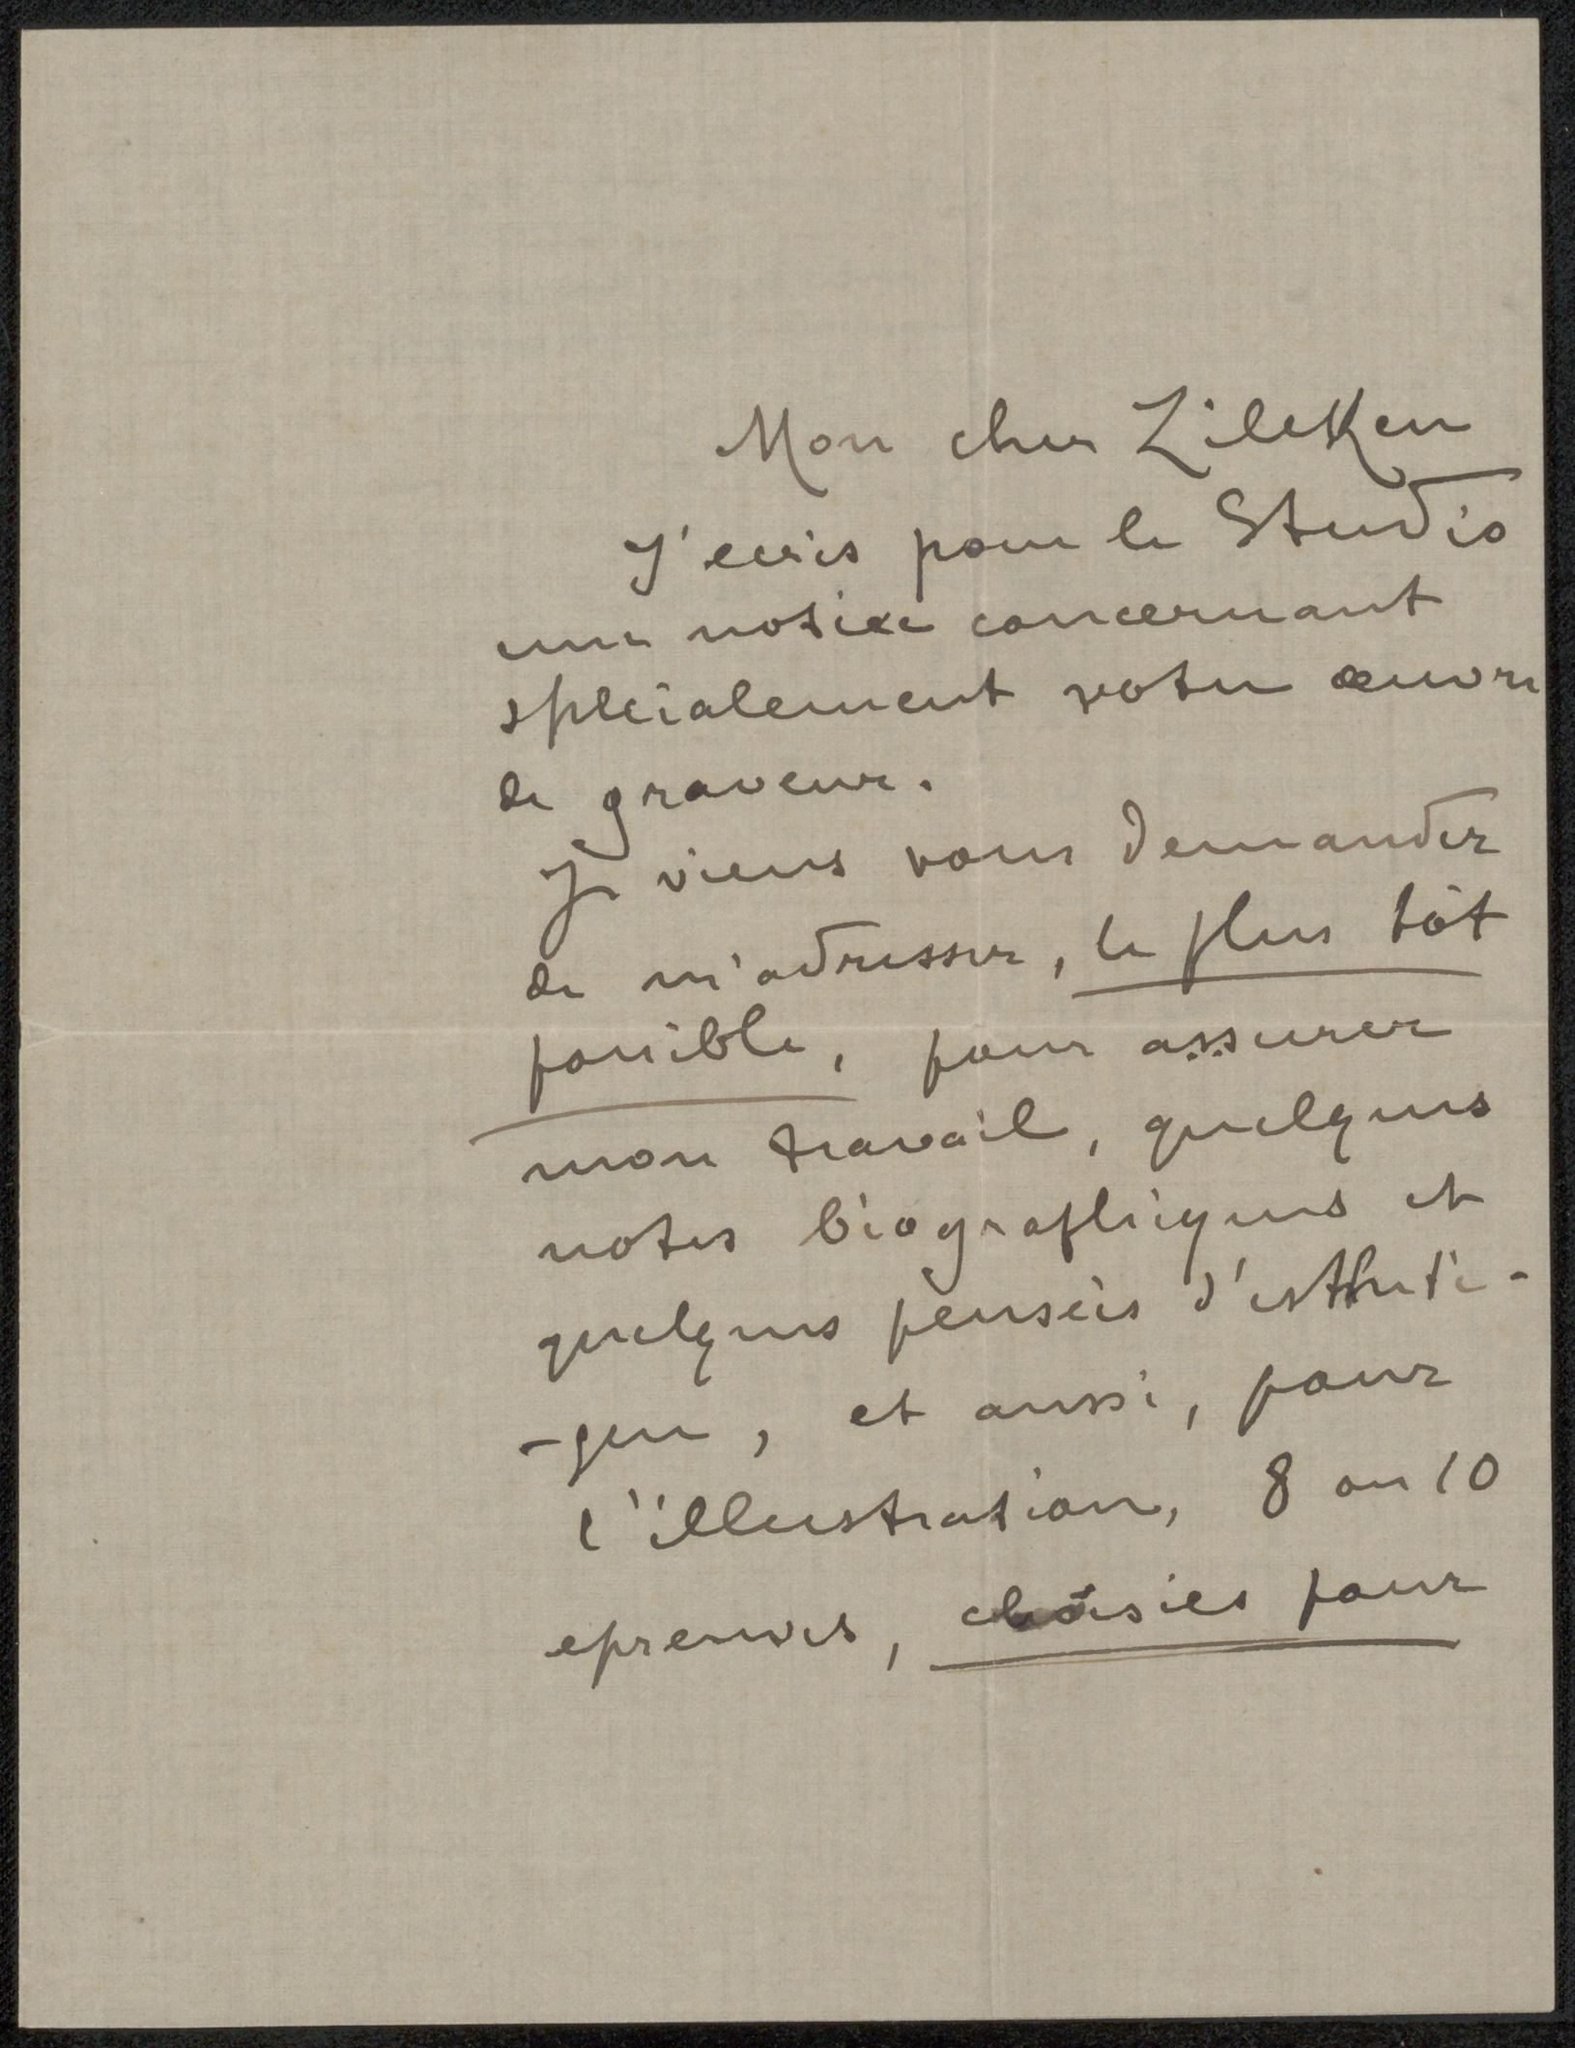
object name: letter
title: Brief aan Philip Zilcken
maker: fernand khnopff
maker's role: draughtsman, print maker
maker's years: 1858-1921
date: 1905-1908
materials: ink, paper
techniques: pen, writing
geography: brussels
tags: publisher, the hague, painter, draughtsman, philip zilcken, the graphic arts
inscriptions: collector's mark: ‘RPK’